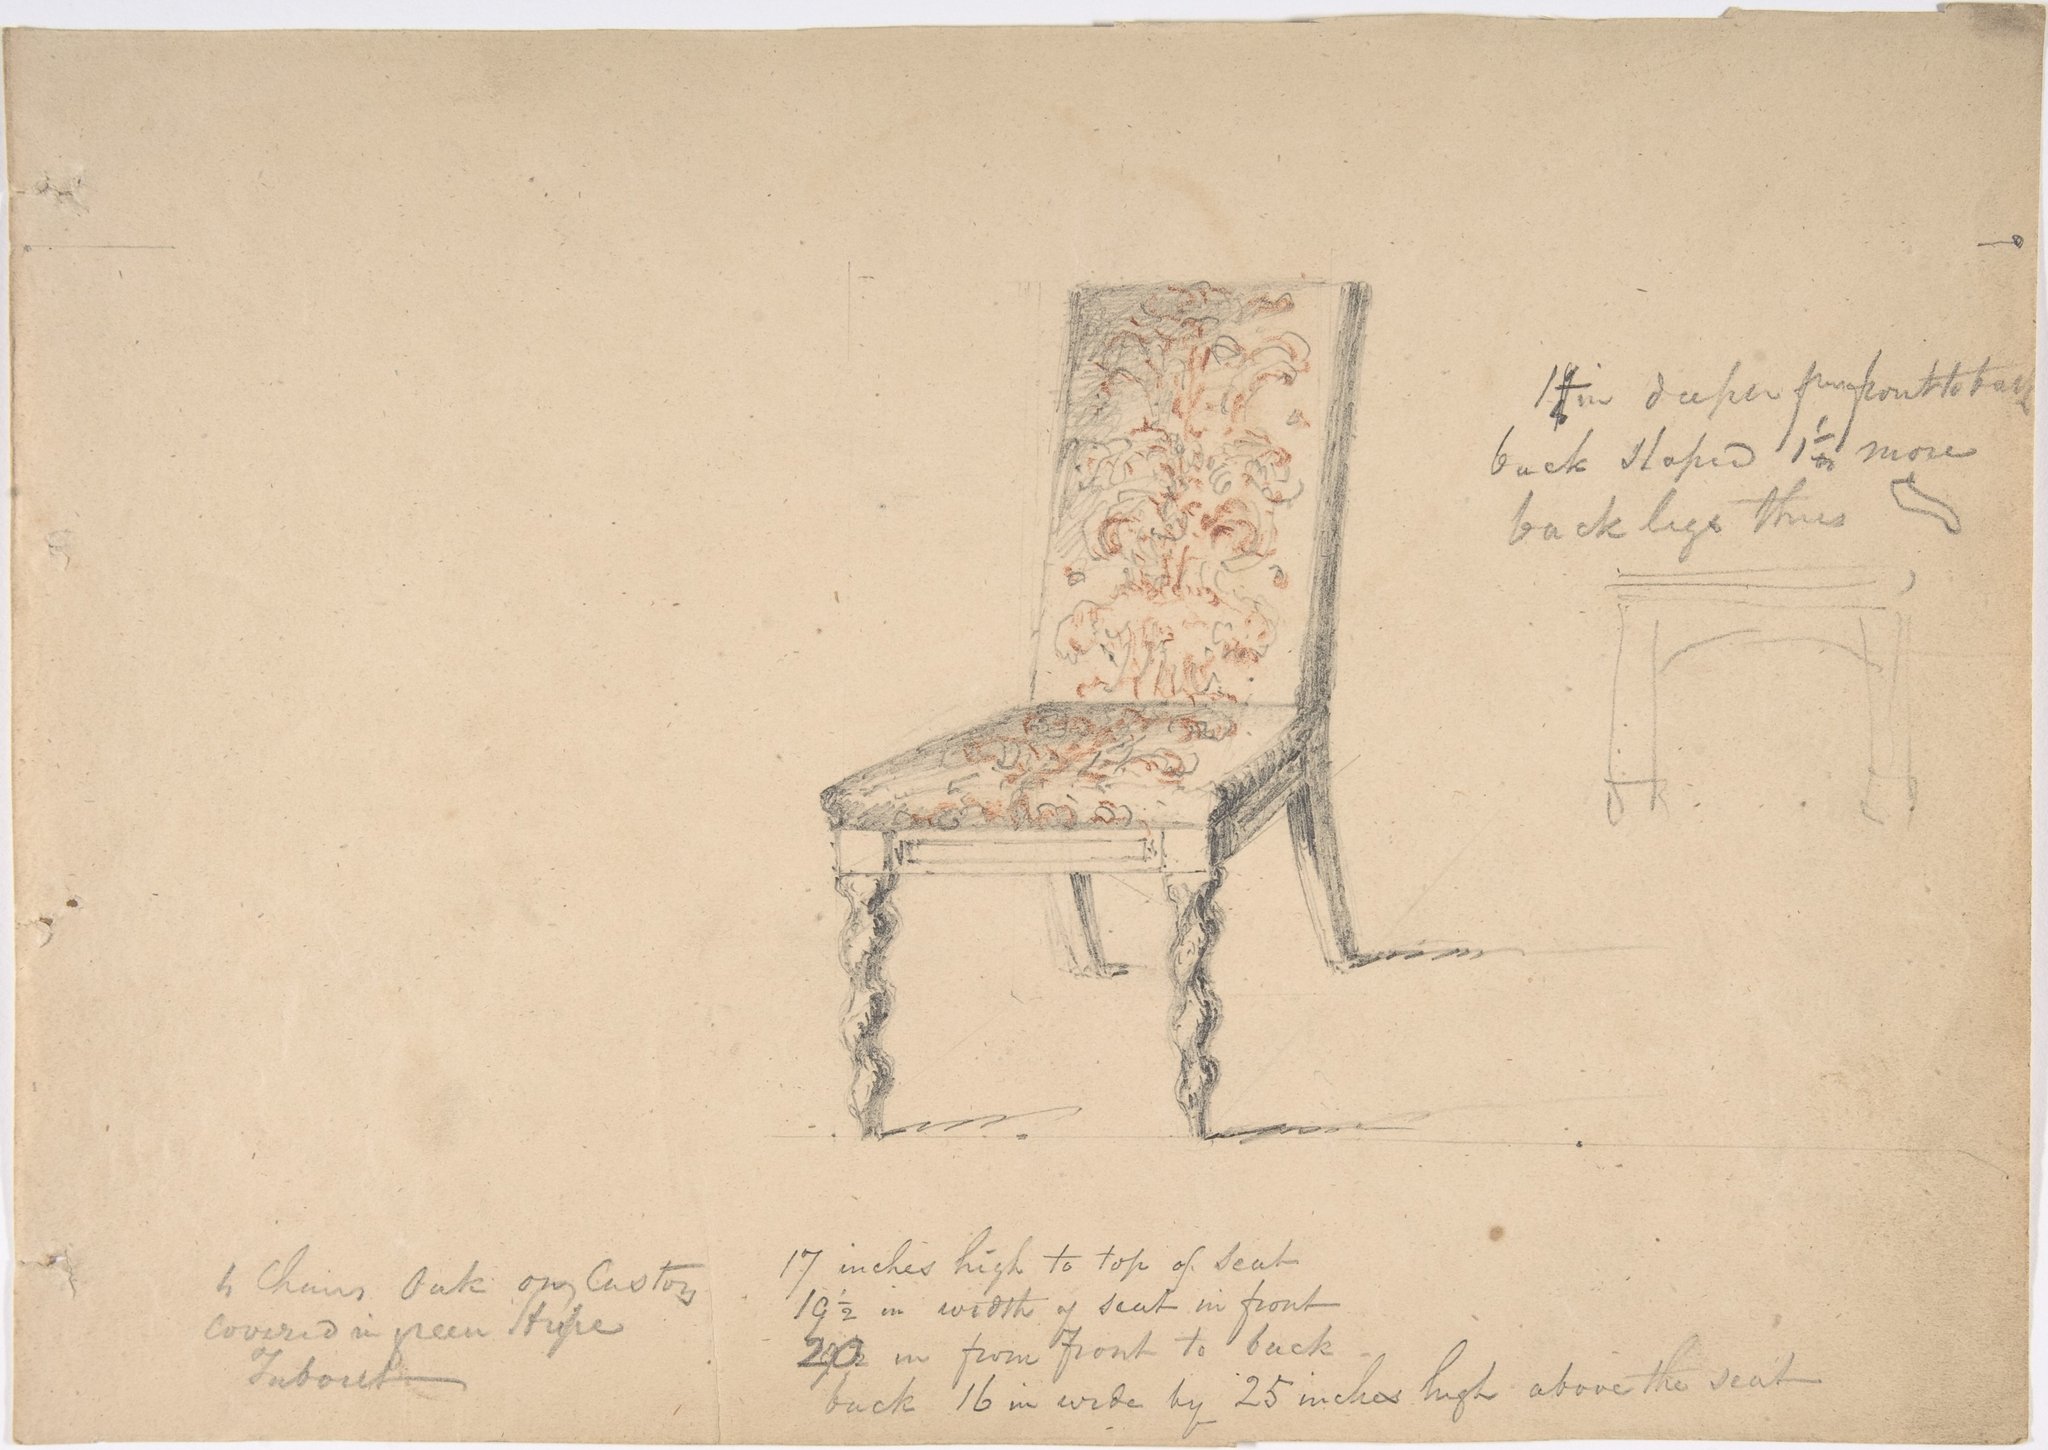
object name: drawing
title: Design for a Chair with Turned Front Legs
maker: anonymous, british, 19th century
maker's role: artist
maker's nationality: british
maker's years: 1800-1900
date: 1801-1833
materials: ink, watercolor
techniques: brush, pen, wash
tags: chairs